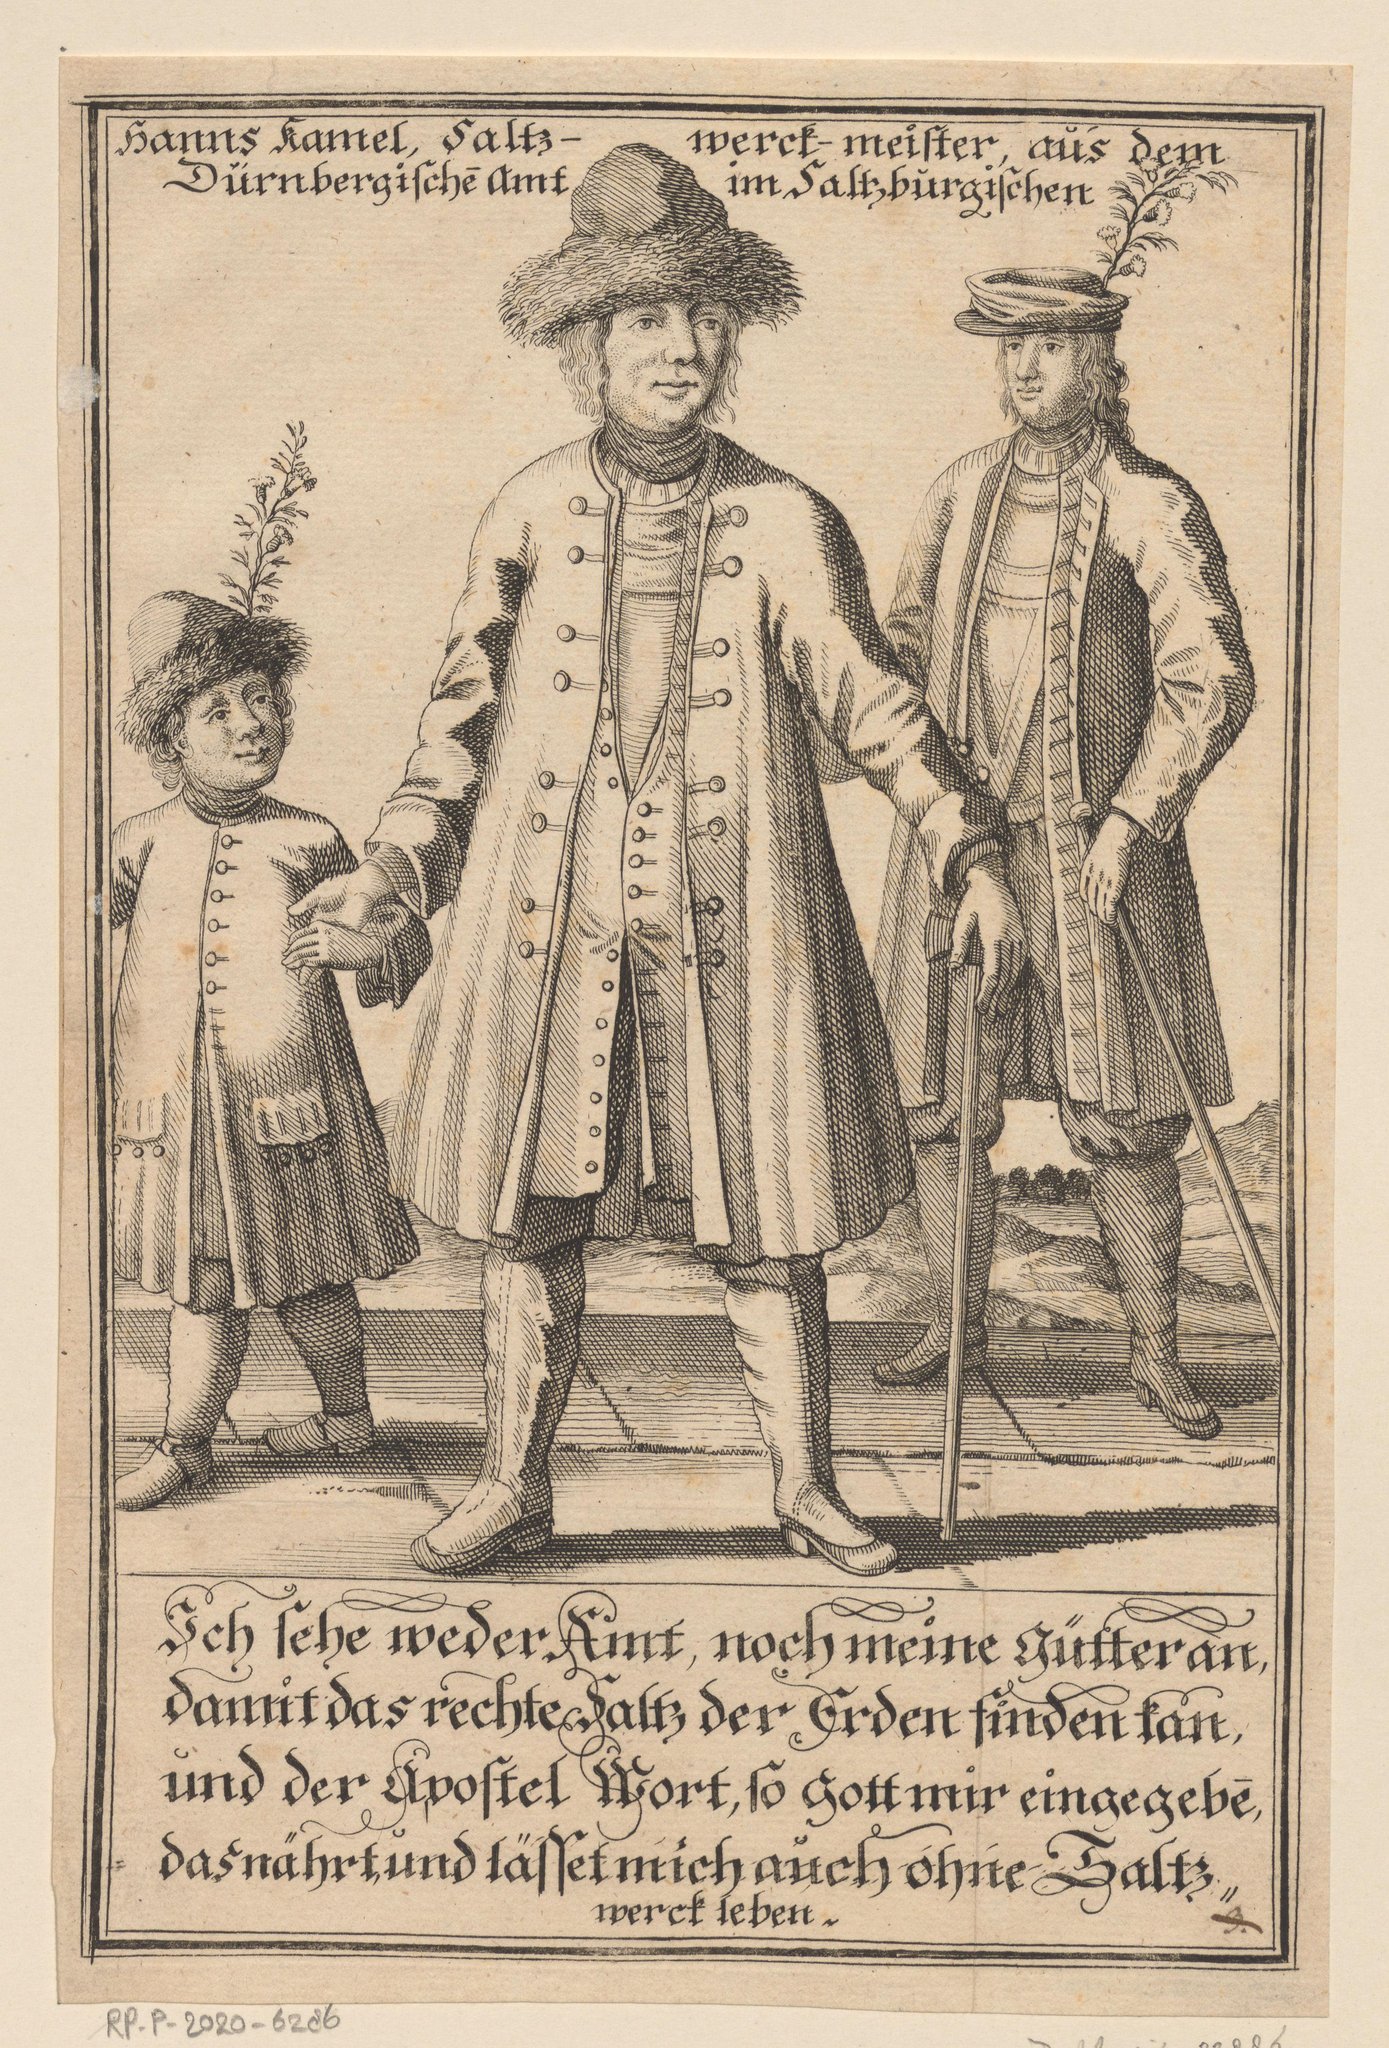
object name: print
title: Portret van Hanns Kamel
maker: Anonymous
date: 1734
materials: paper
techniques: etching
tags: historical persons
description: Prent mogelijk uit: Baum, Johann Heinrich. Nachlese zu der Salzburgischen Emigranten Wanderschafft (...). Neurenberg: Peter Conrad Monath, 1734.